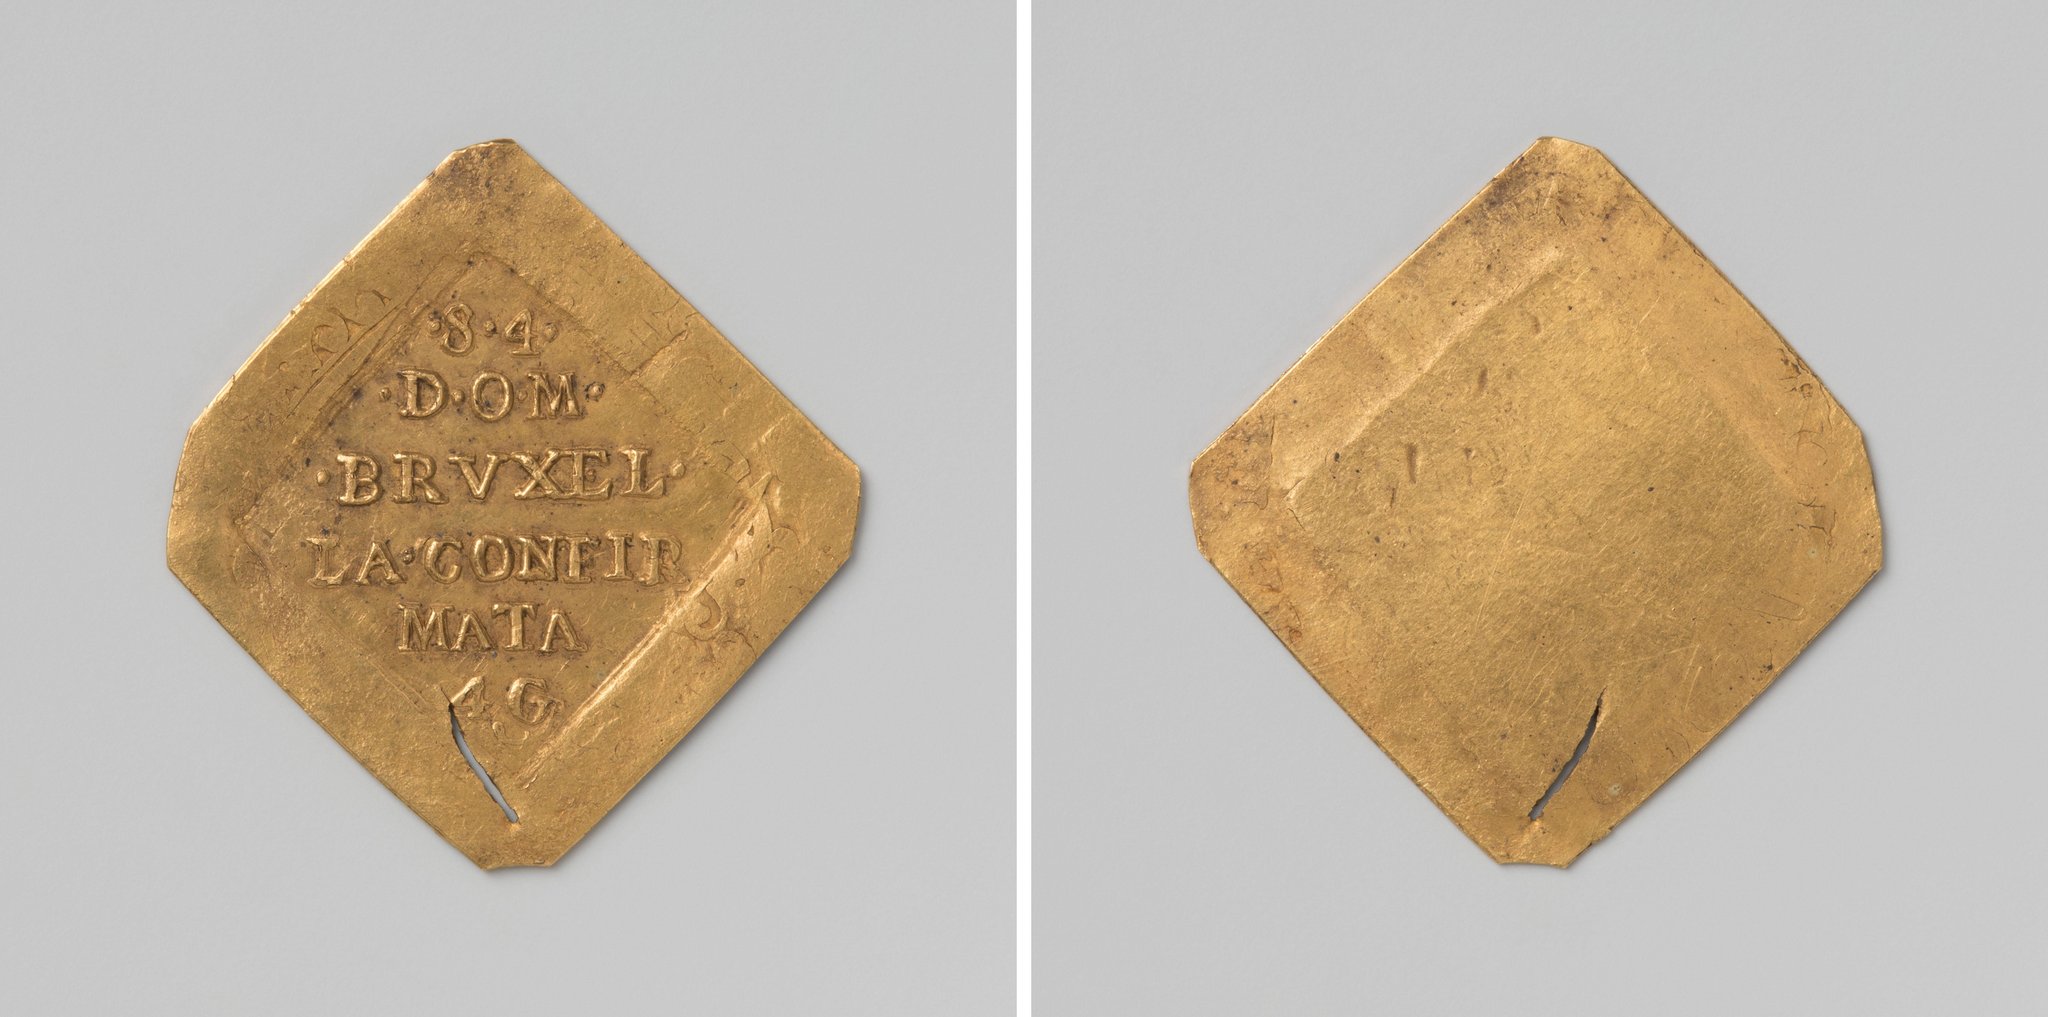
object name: copy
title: Vier gulden, noodmunt uit Brussel, vervalsing van een noodmunt geslagen tijdens het beleg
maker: Anonymous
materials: gold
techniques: striking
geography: belgium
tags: brussels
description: eenzijdige, rechthoekige noodmunt met afgeschuinde hoeken. Voorzijde: een ruitvormige stempel: opschrift; onder voorstelling nog sporen van oudere stempel. Keerzijde: blanco